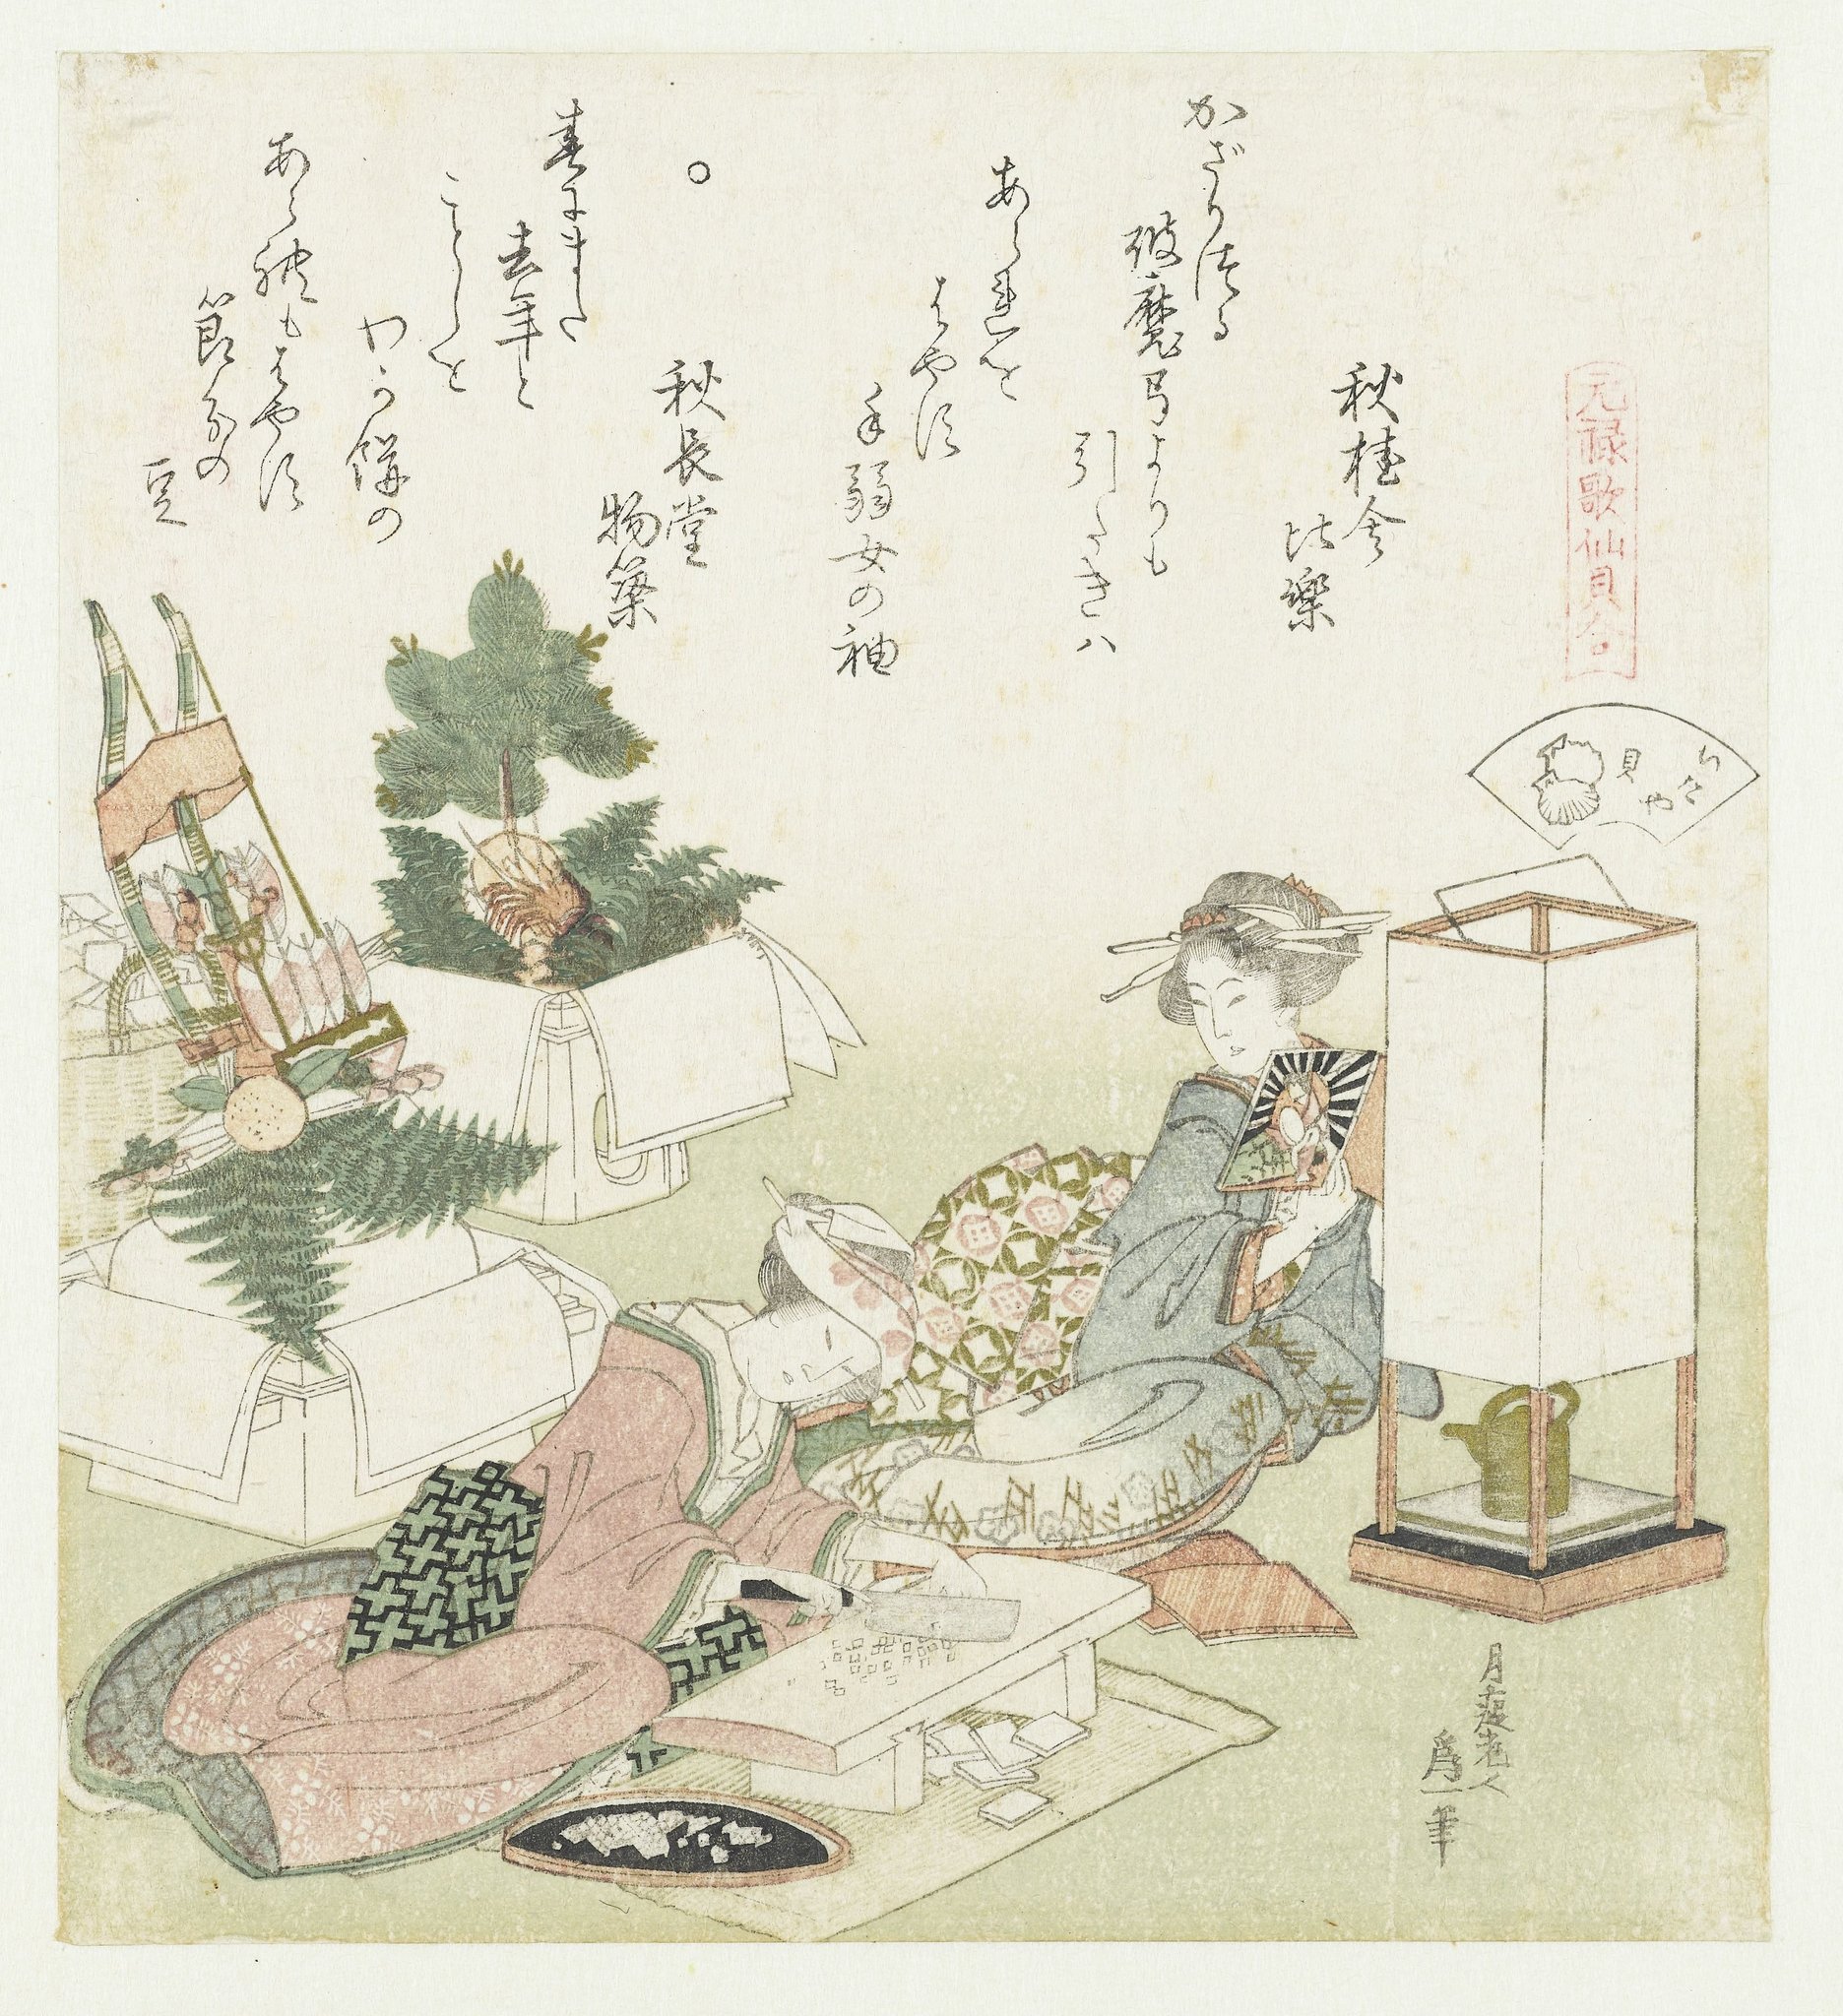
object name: surimono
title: Itayagai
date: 1821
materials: paper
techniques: blind stamped, woodcut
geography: japan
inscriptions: collector's mark, passe-partout, bottom left, printed: JABdH with a rooster., collector's mark, verso, stamped: Lugt 2228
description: Een surimono is een luxe uitgevoerde prent waarop beeld met één of meerdere gedichten gecombineerd is. Bij het drukken van een surimono werd vaak gebruik gemaakt van dikker papier, blinddruk en metaal pigmenten, zoals koper- en zilverpoeder. De prenten werden vaak in opdracht van dichters gemaakt en als exclusief geschenk aan vrienden en relaties gegeven.